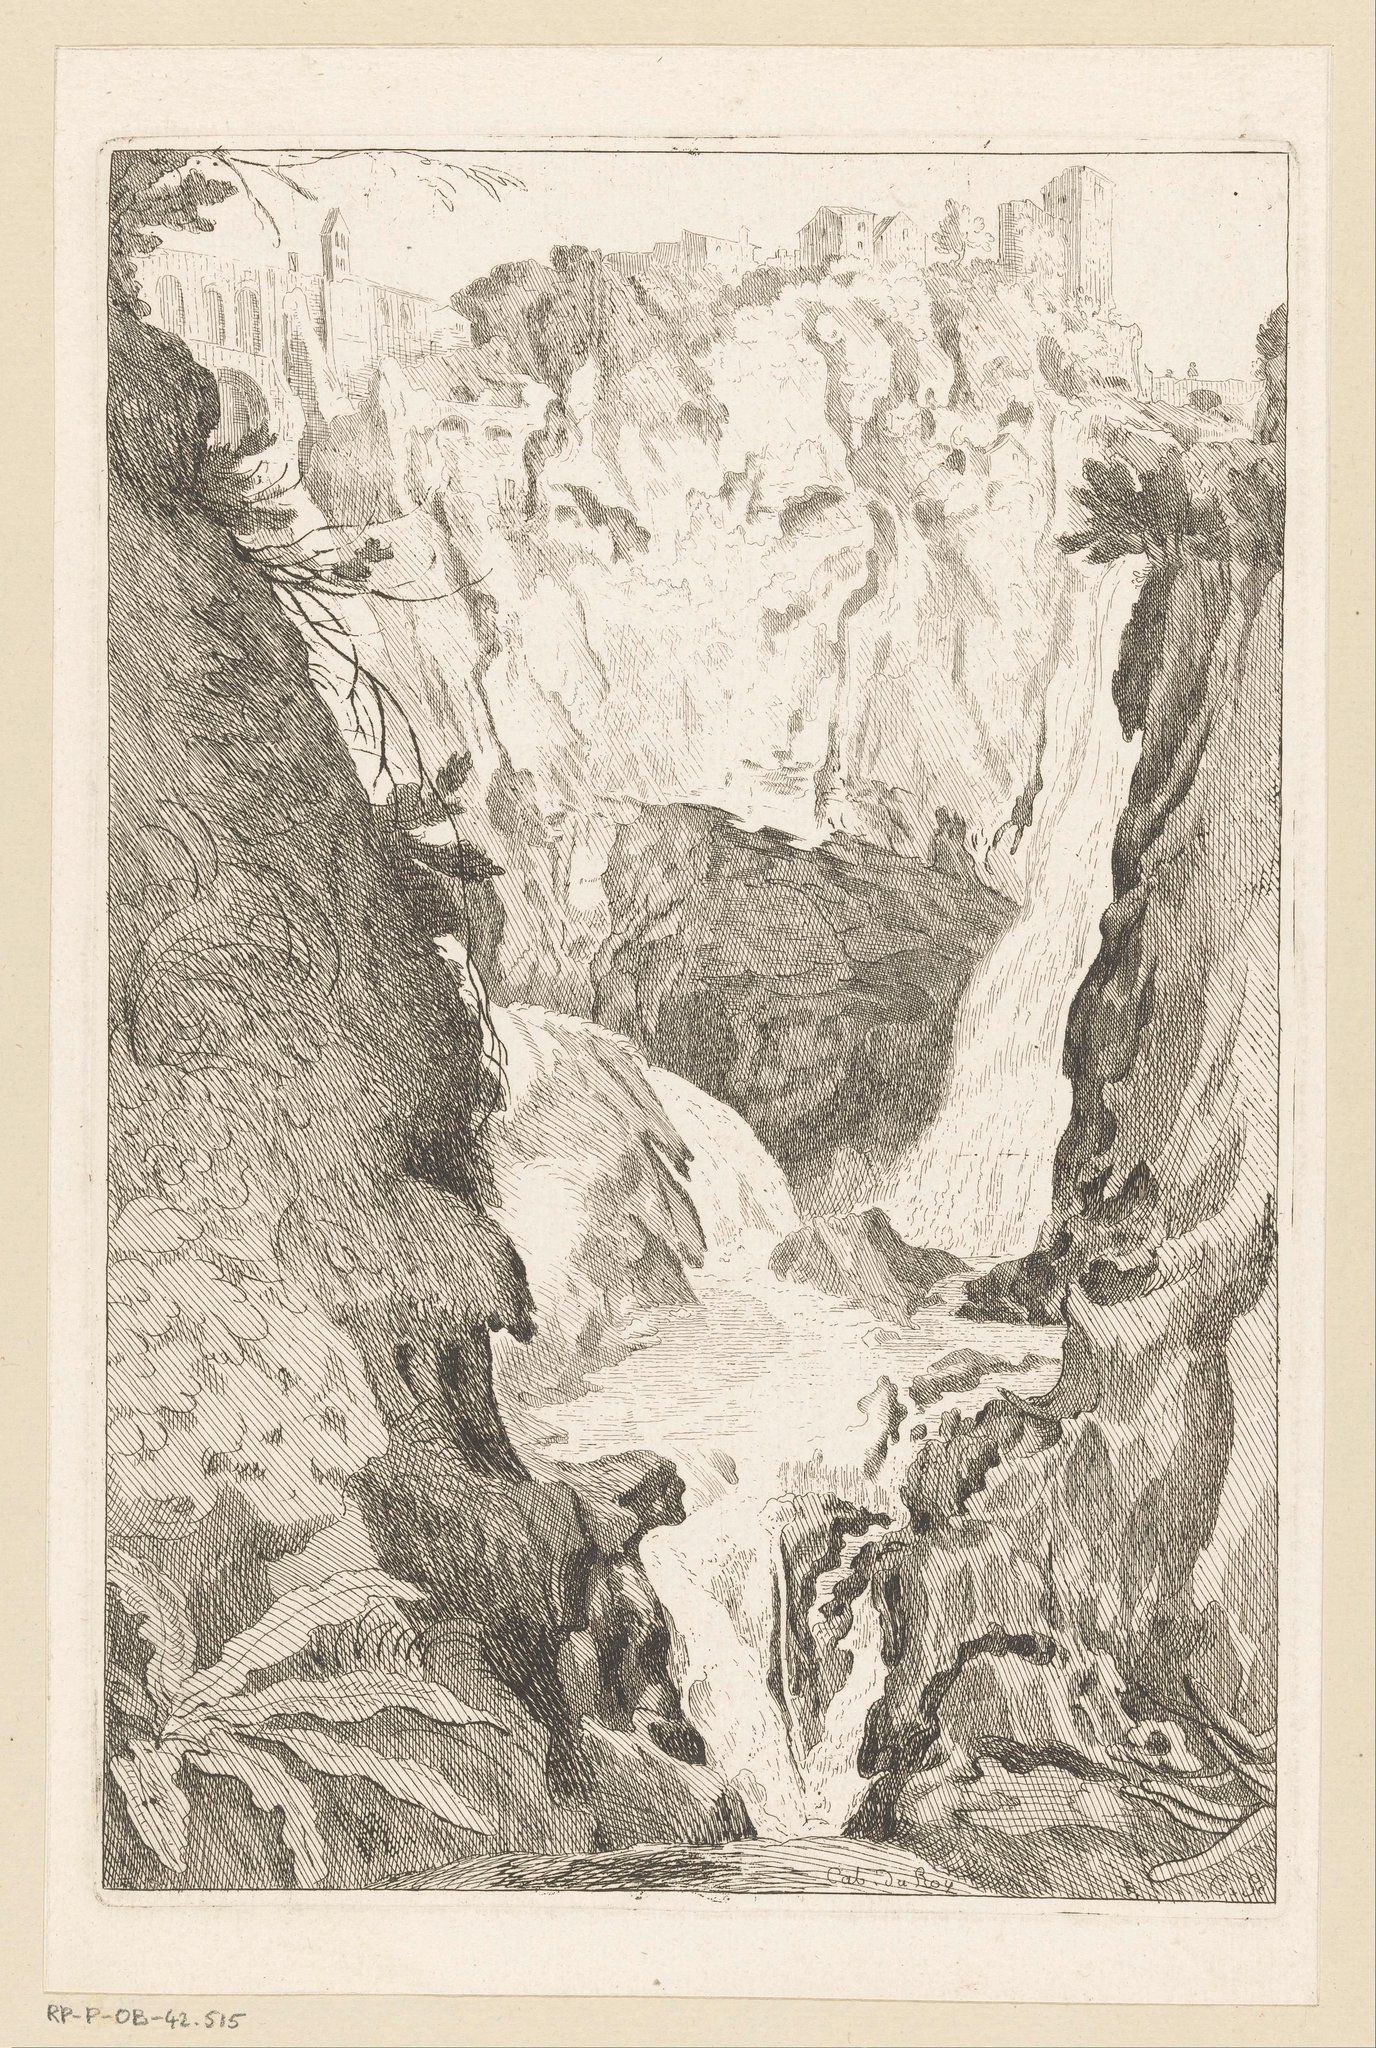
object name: print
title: Waterval met bovenaan een stad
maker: anne claude philippe caylus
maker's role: print maker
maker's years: 1692-1765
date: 1702-1765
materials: paper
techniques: etching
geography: france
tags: waterfall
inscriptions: collector's mark: Lugt 240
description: Maakt deel uit van een serie getiteld: "Cabinet du Roy" van 222 etsen naar tekeningen uit de Franse koninklijke collectie.